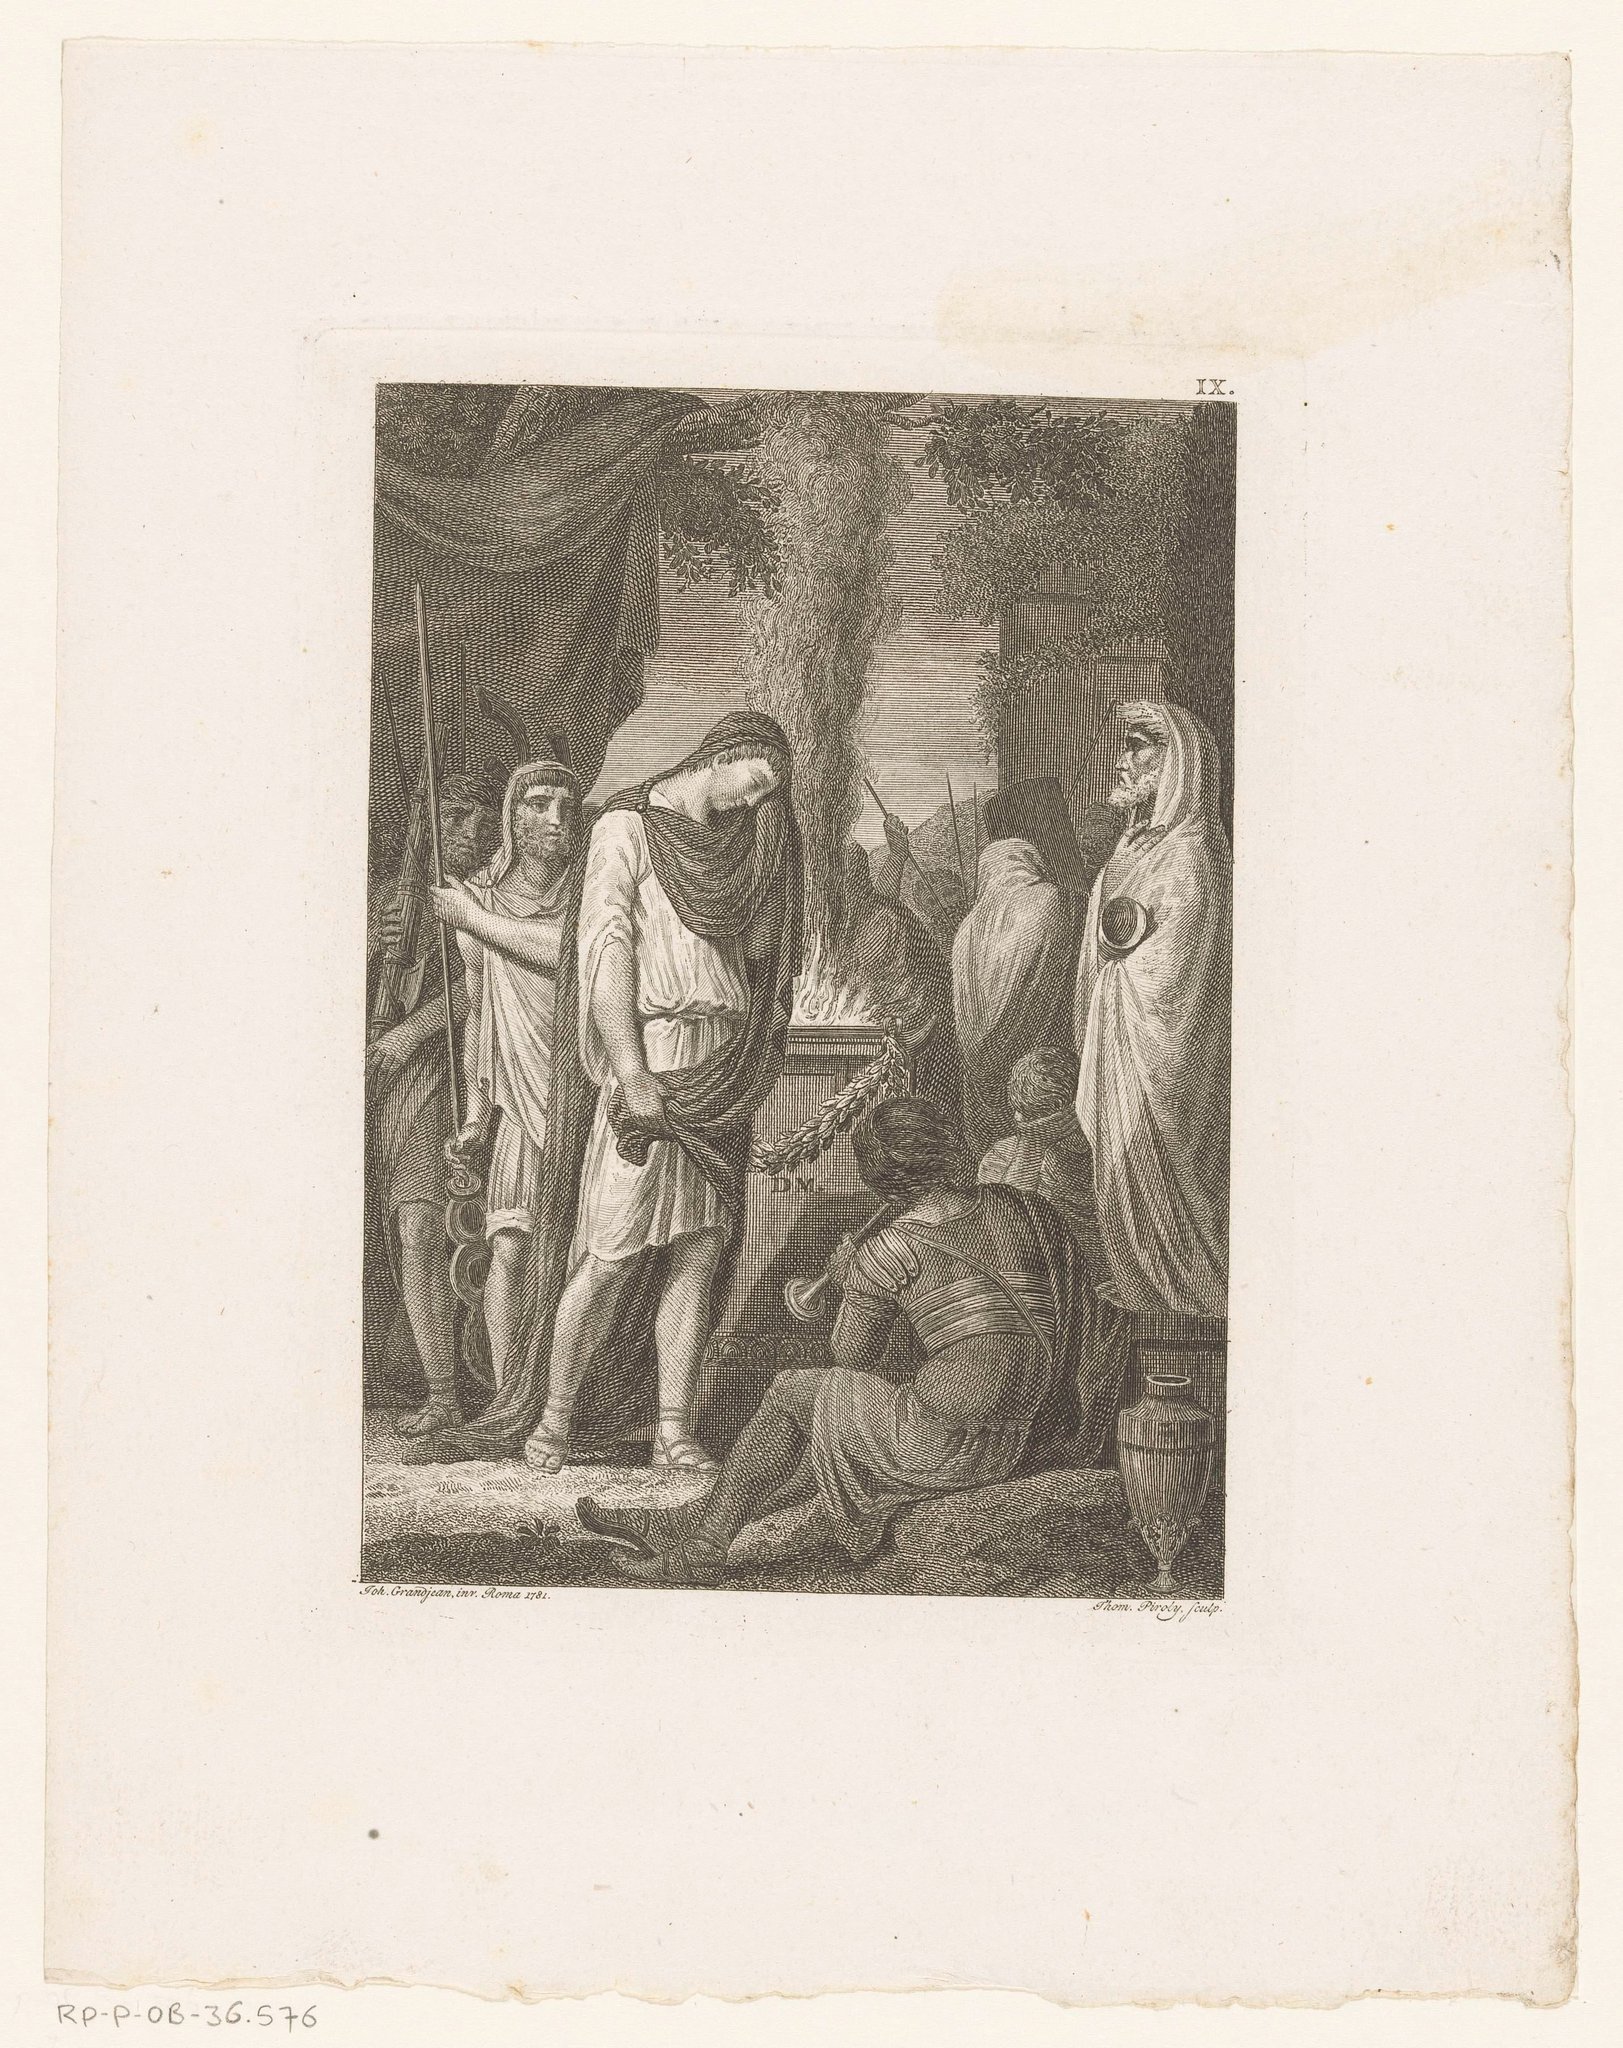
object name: print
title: Germanicus bij een brandend offer op een altaar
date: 1779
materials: paper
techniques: engraving, etching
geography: italy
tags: (story of) germanicus, sacrifice ~ roman religion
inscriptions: collector's mark: Lugt 2228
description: Prent gebruikt voor de publicatie: Winter, Lucretia Wilhelmina van. Germanicus: In zestien boeken. Amsterdam: P. Meijer, 1779.